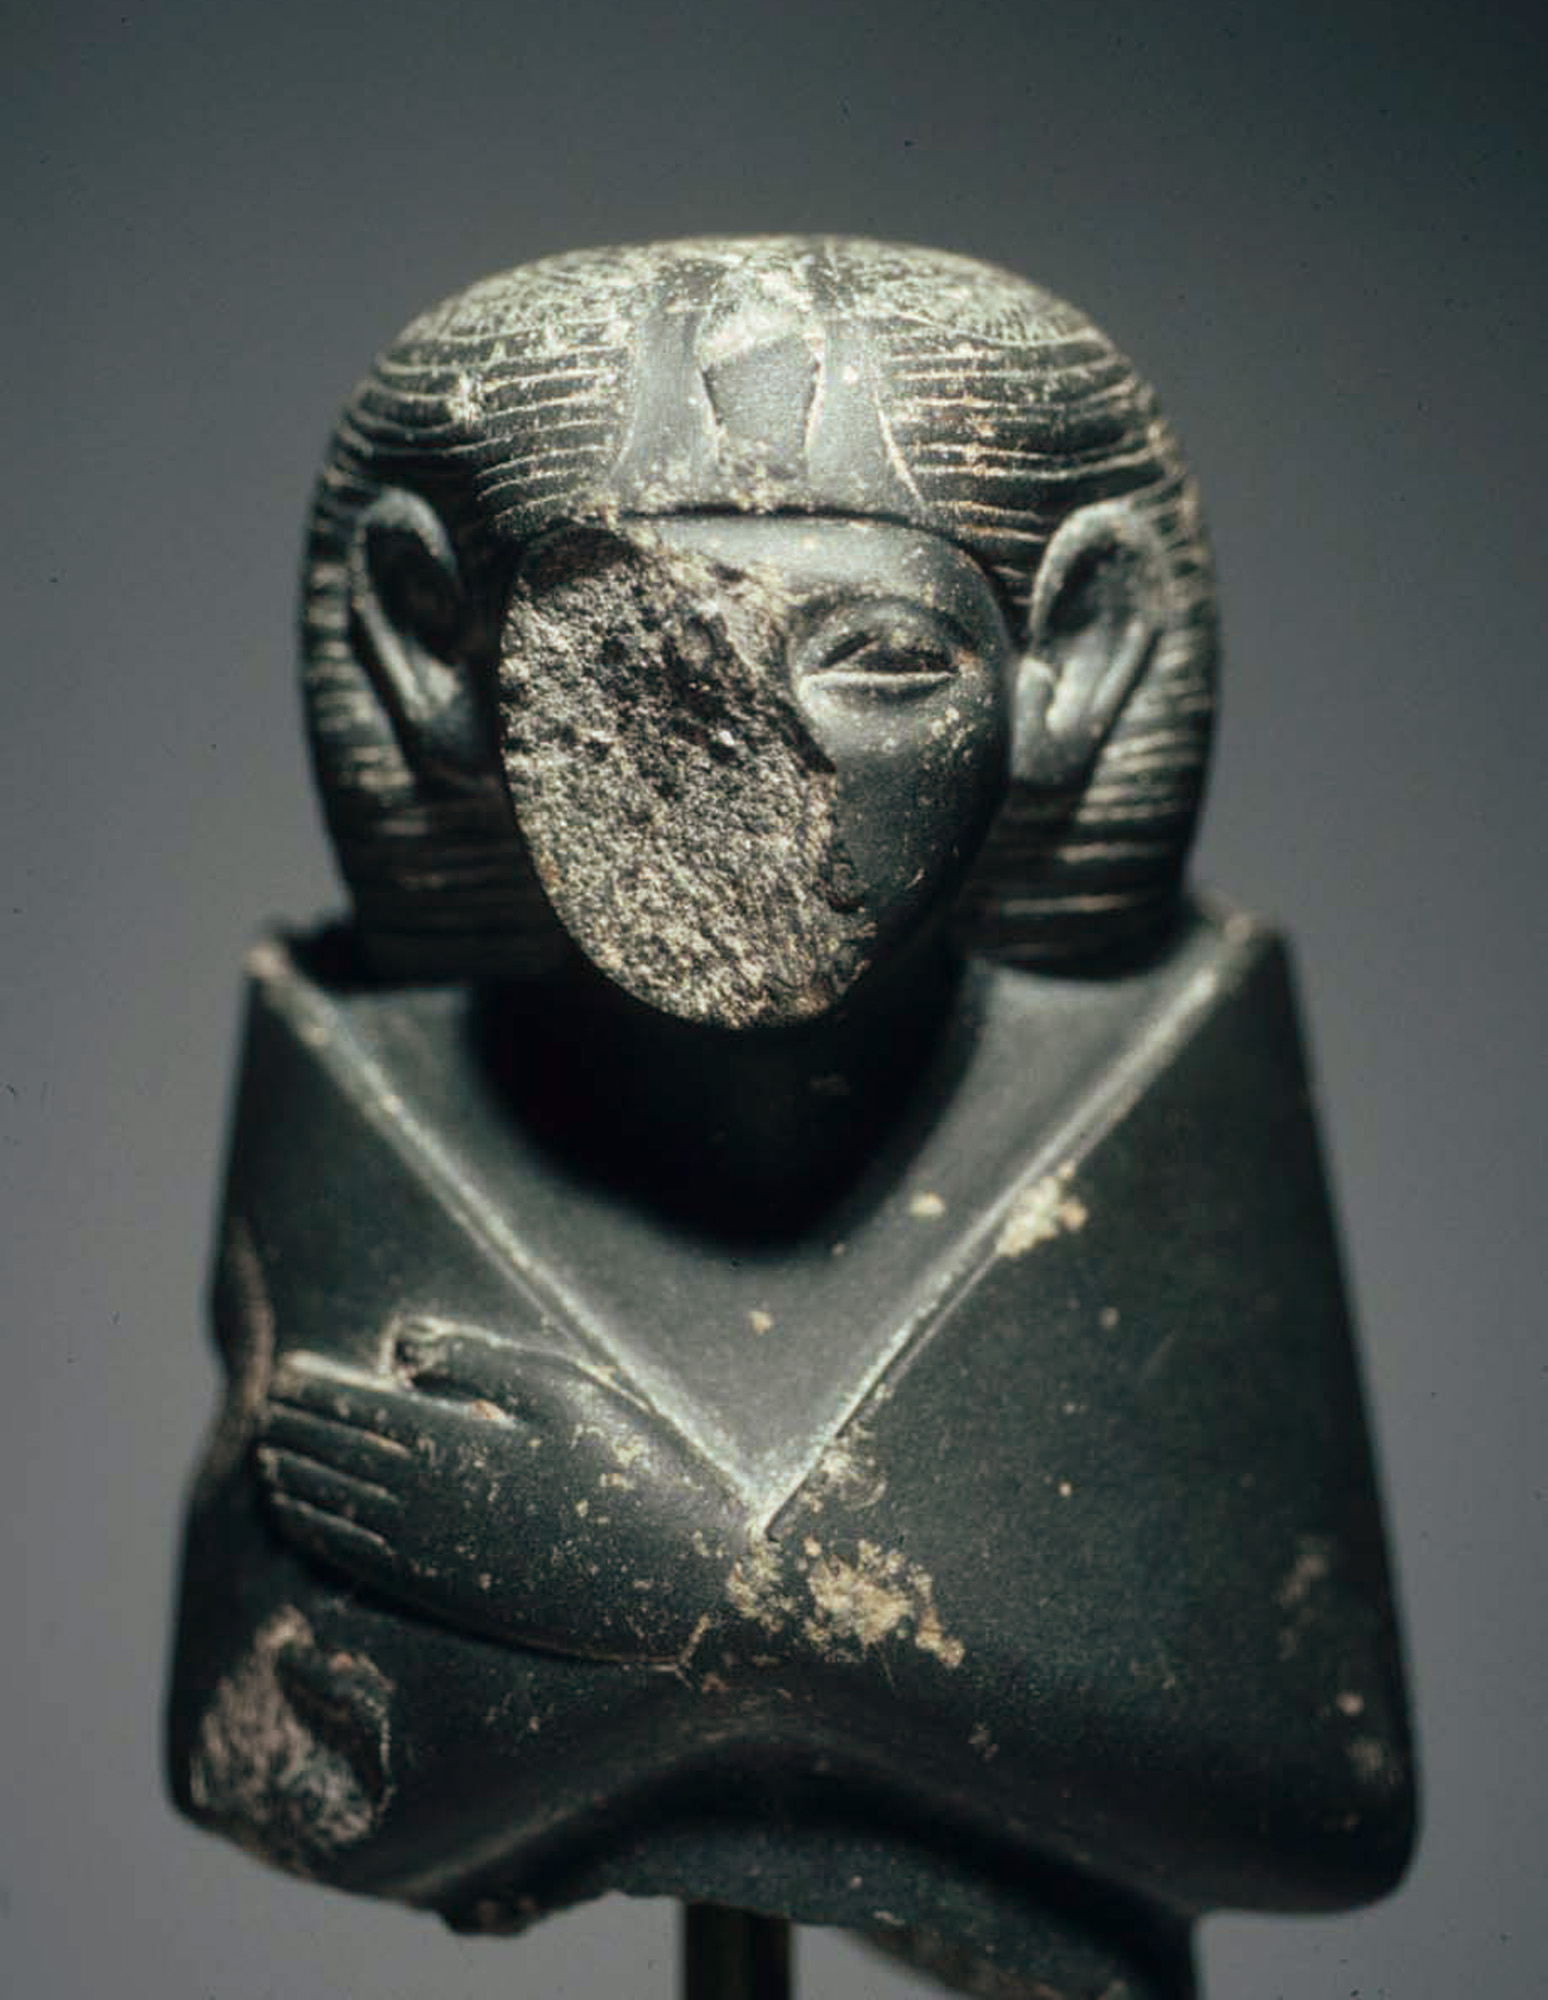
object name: statuette, late middle kingdom queen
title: Statuette of a Late Middle Kingdom Queen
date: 1825-1750 BCE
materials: stone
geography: egypt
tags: queens,mk-kings